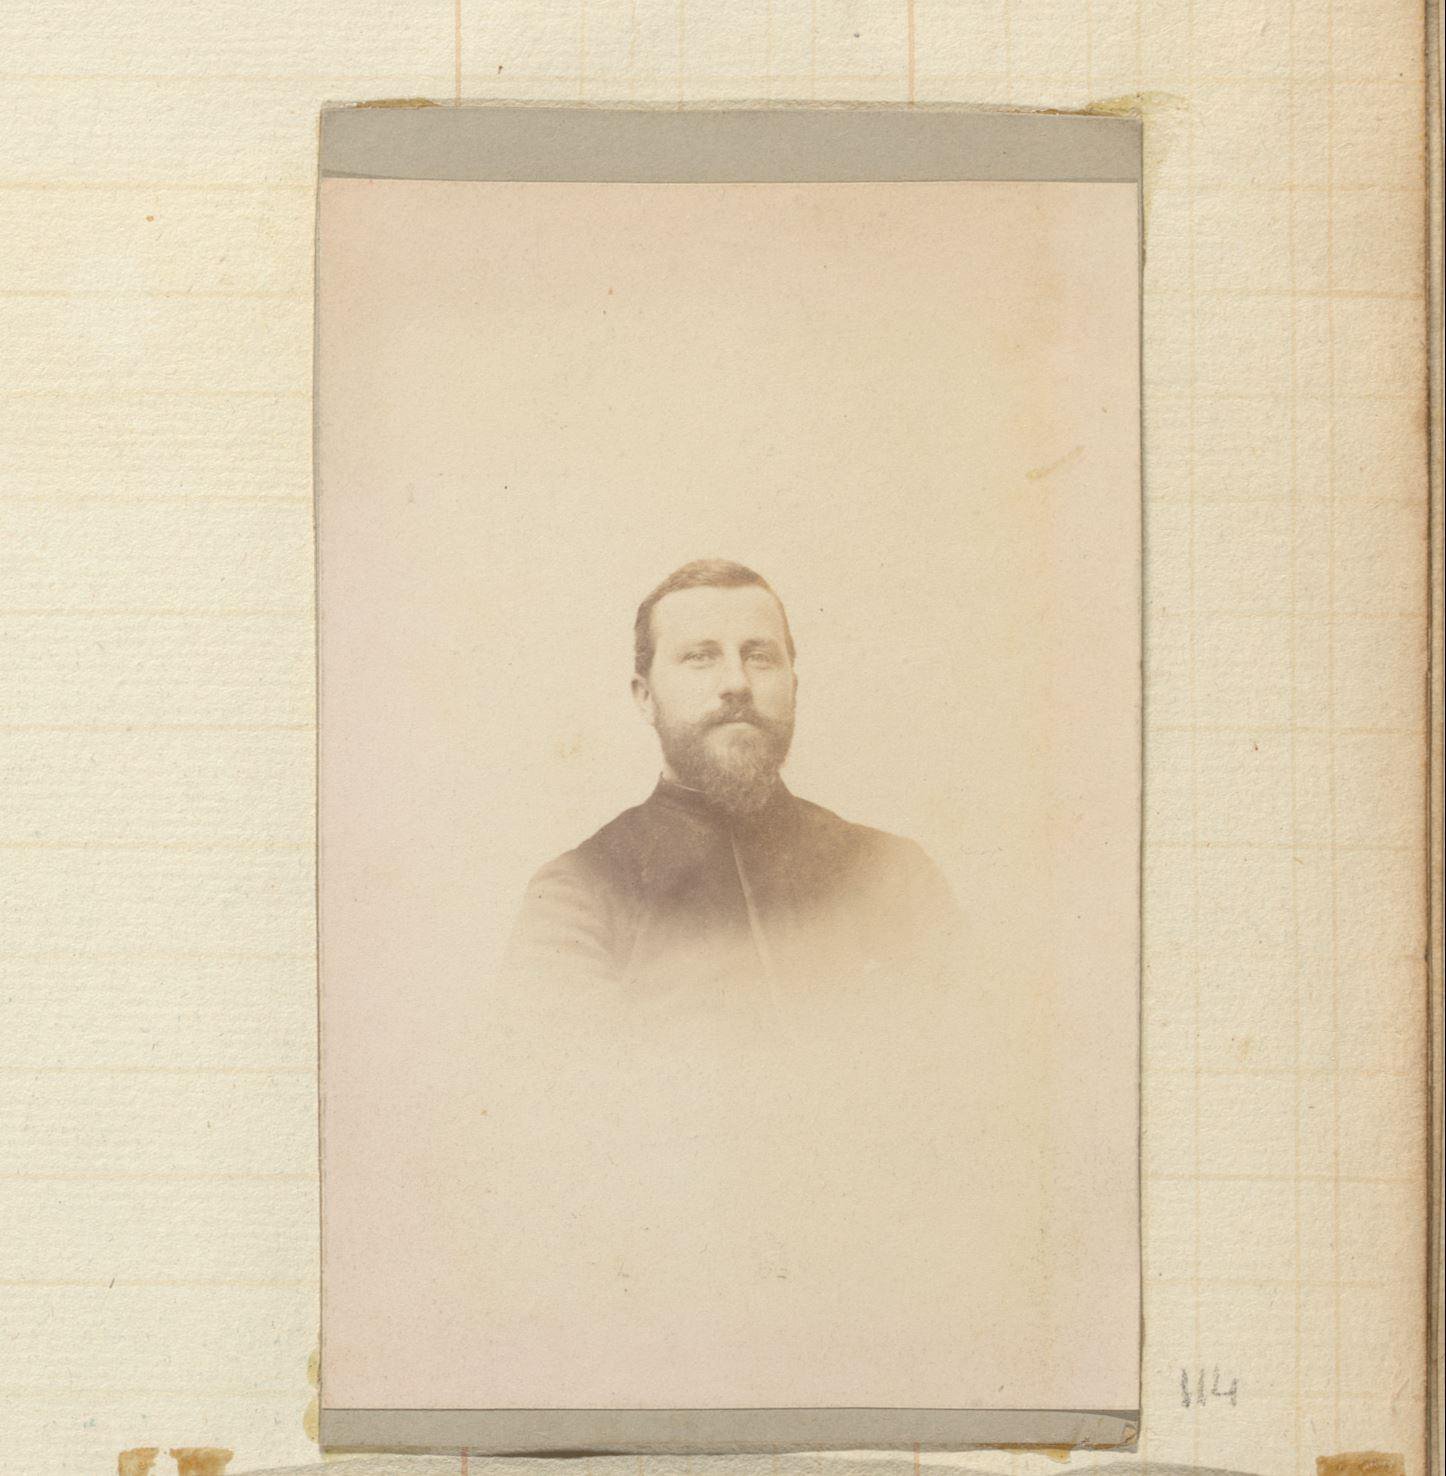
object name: carte de visite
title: Portret van een man met een baard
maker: Anonymous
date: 1880-1900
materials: paper, photographic support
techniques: albumen print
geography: france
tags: adult man, beard